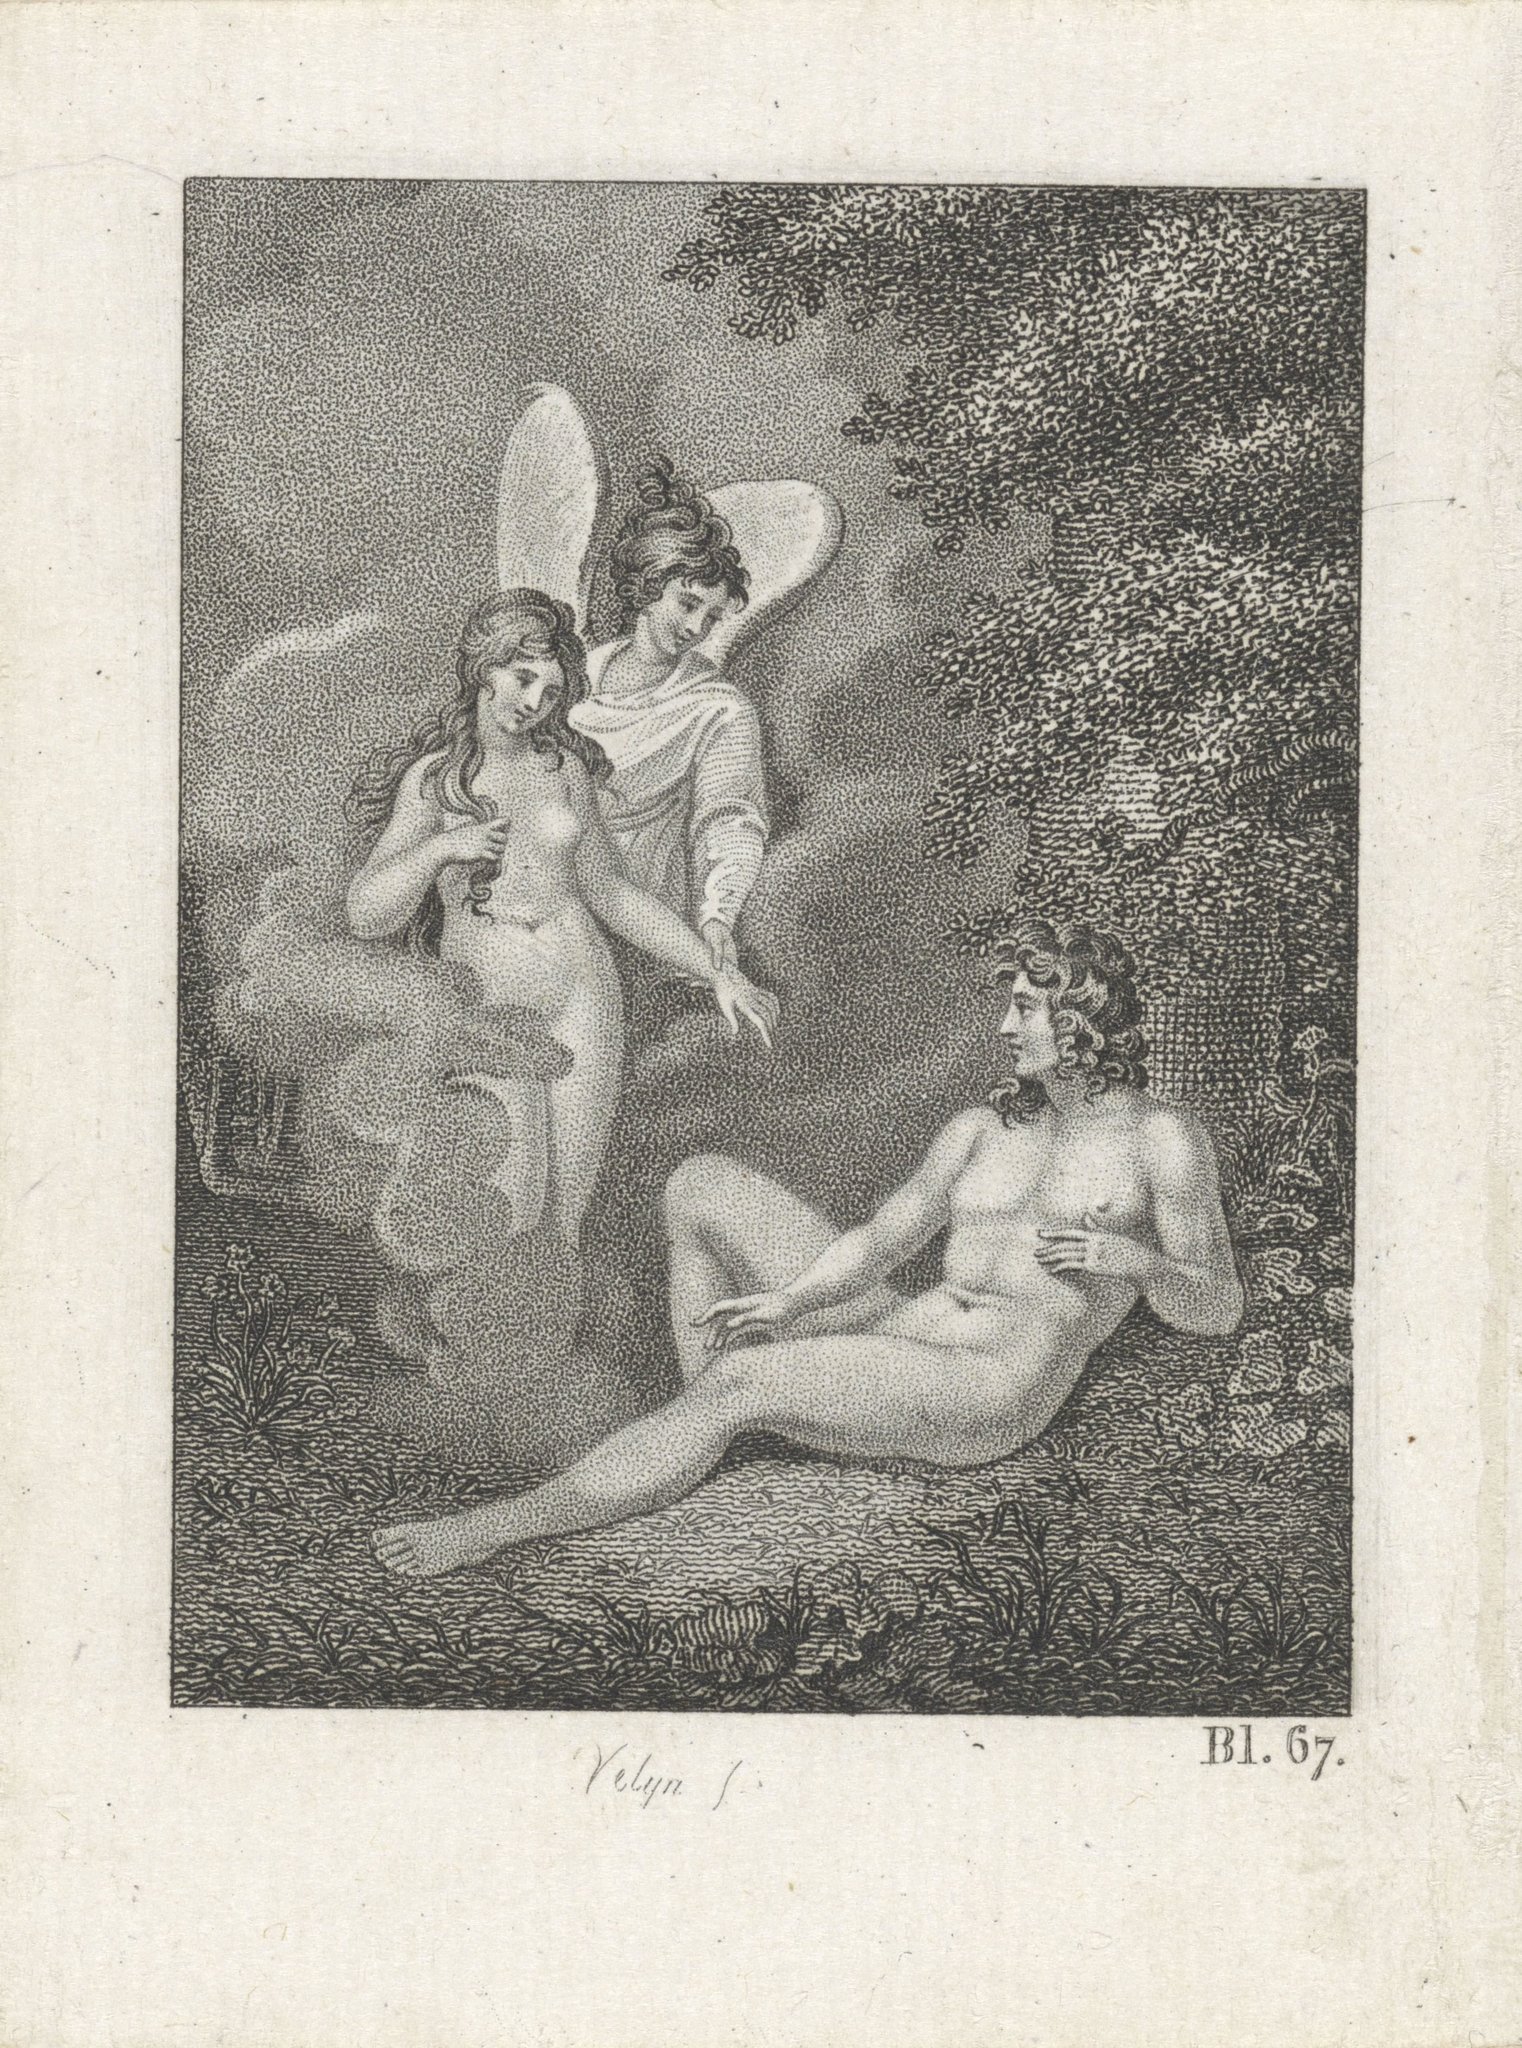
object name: print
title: Engel en een vrouw verschijnen aan een naakte man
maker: philippus velijn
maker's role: print maker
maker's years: 1787-1836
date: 1820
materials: paper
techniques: engraving, etching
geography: netherlands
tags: adolescent, young woman, maiden, materialization, appearance of spirit or ghost, human figure of ideal proportions, e.g. academic nude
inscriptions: collector's mark: Lugt 2228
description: Een engel en een naakte vrouw verschijnen tussen wolken aan een liggende naakte man onder een boom. Rechtsonder: bl. 67.